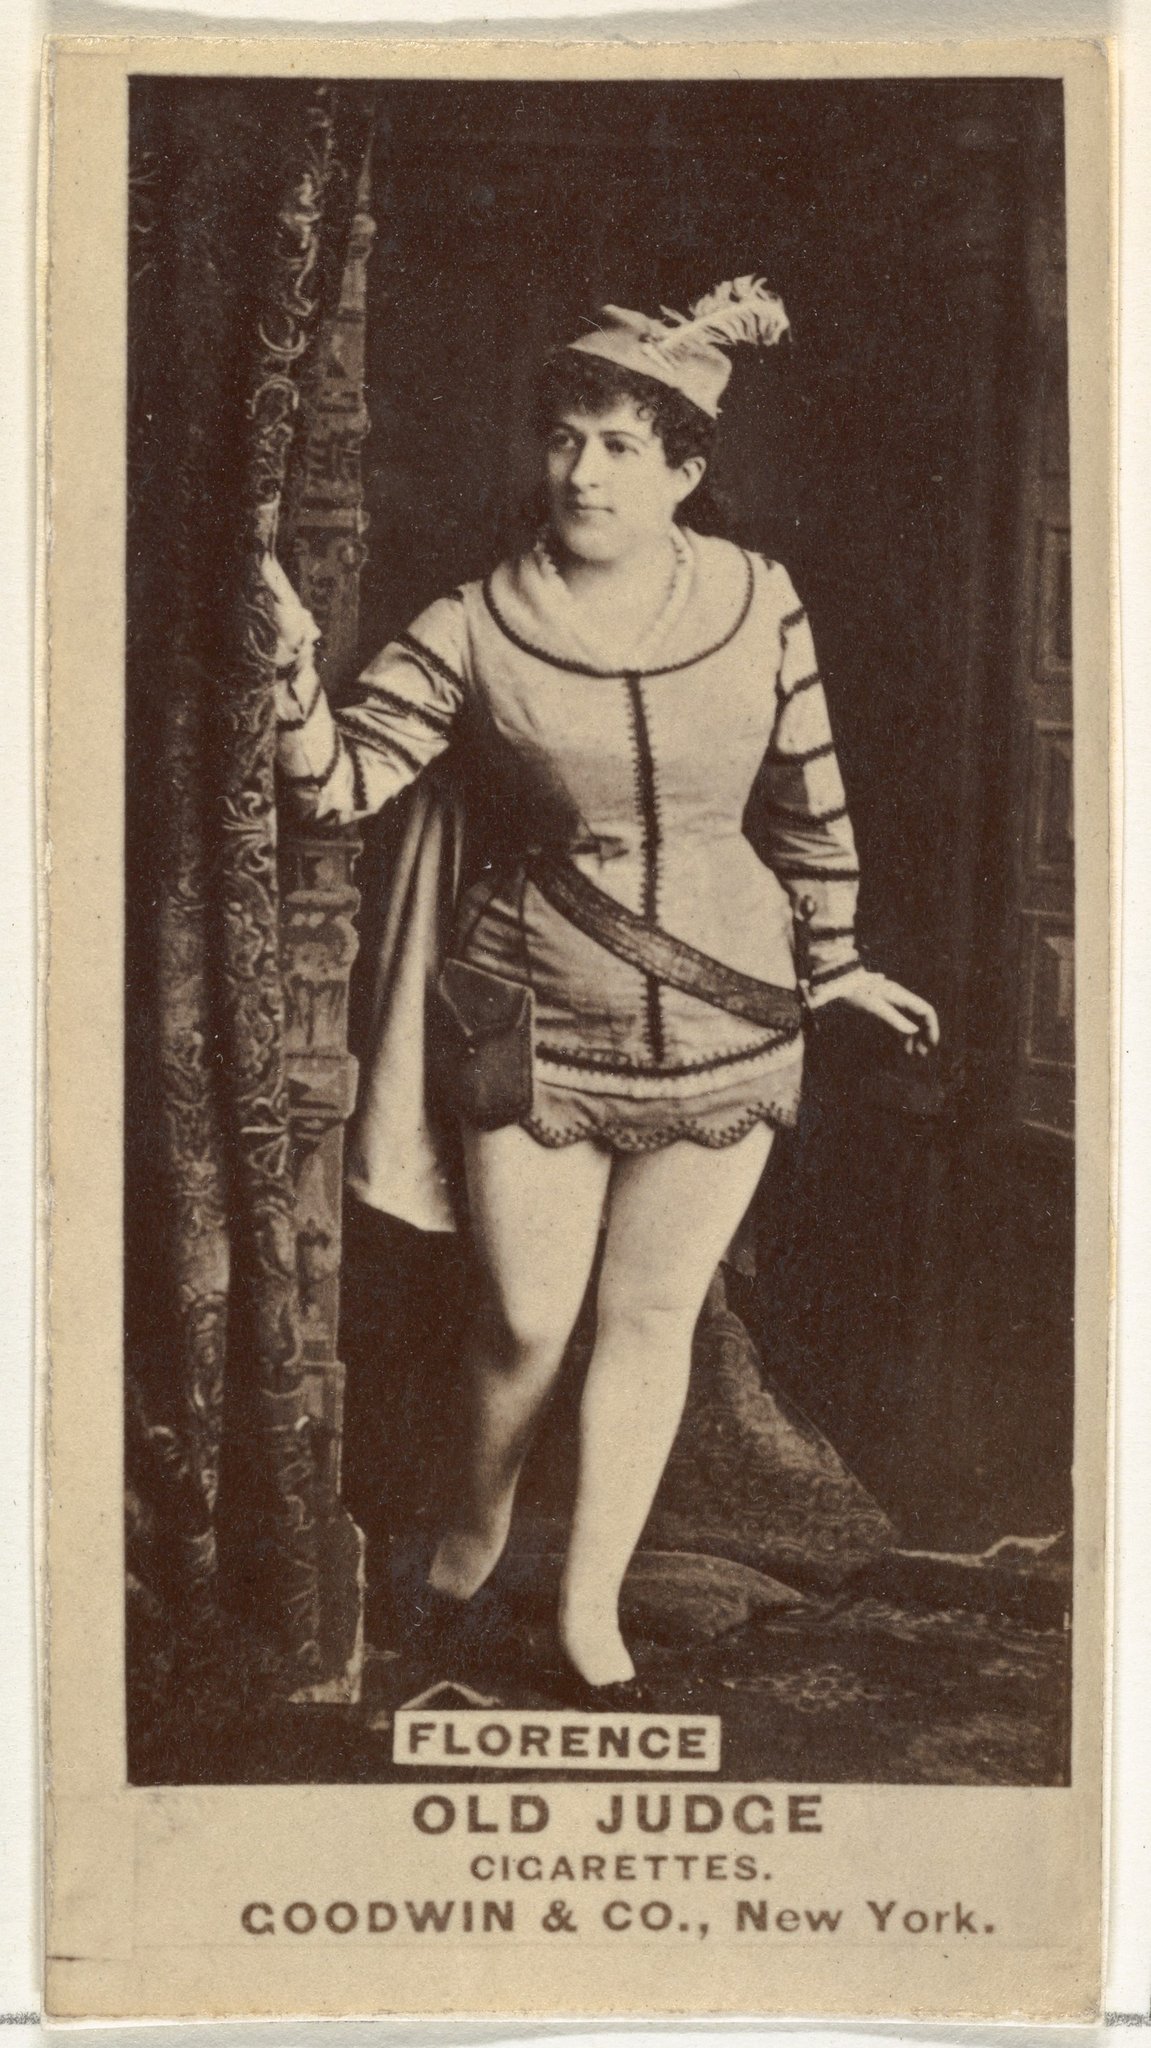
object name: photograph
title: Florence, from the Actors and Actresses series (N171) for Old Judge Cigarettes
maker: goodwin & company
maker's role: publisher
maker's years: 1850-1950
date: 1886-1890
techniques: albumen silver print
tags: portraits,women,actresses